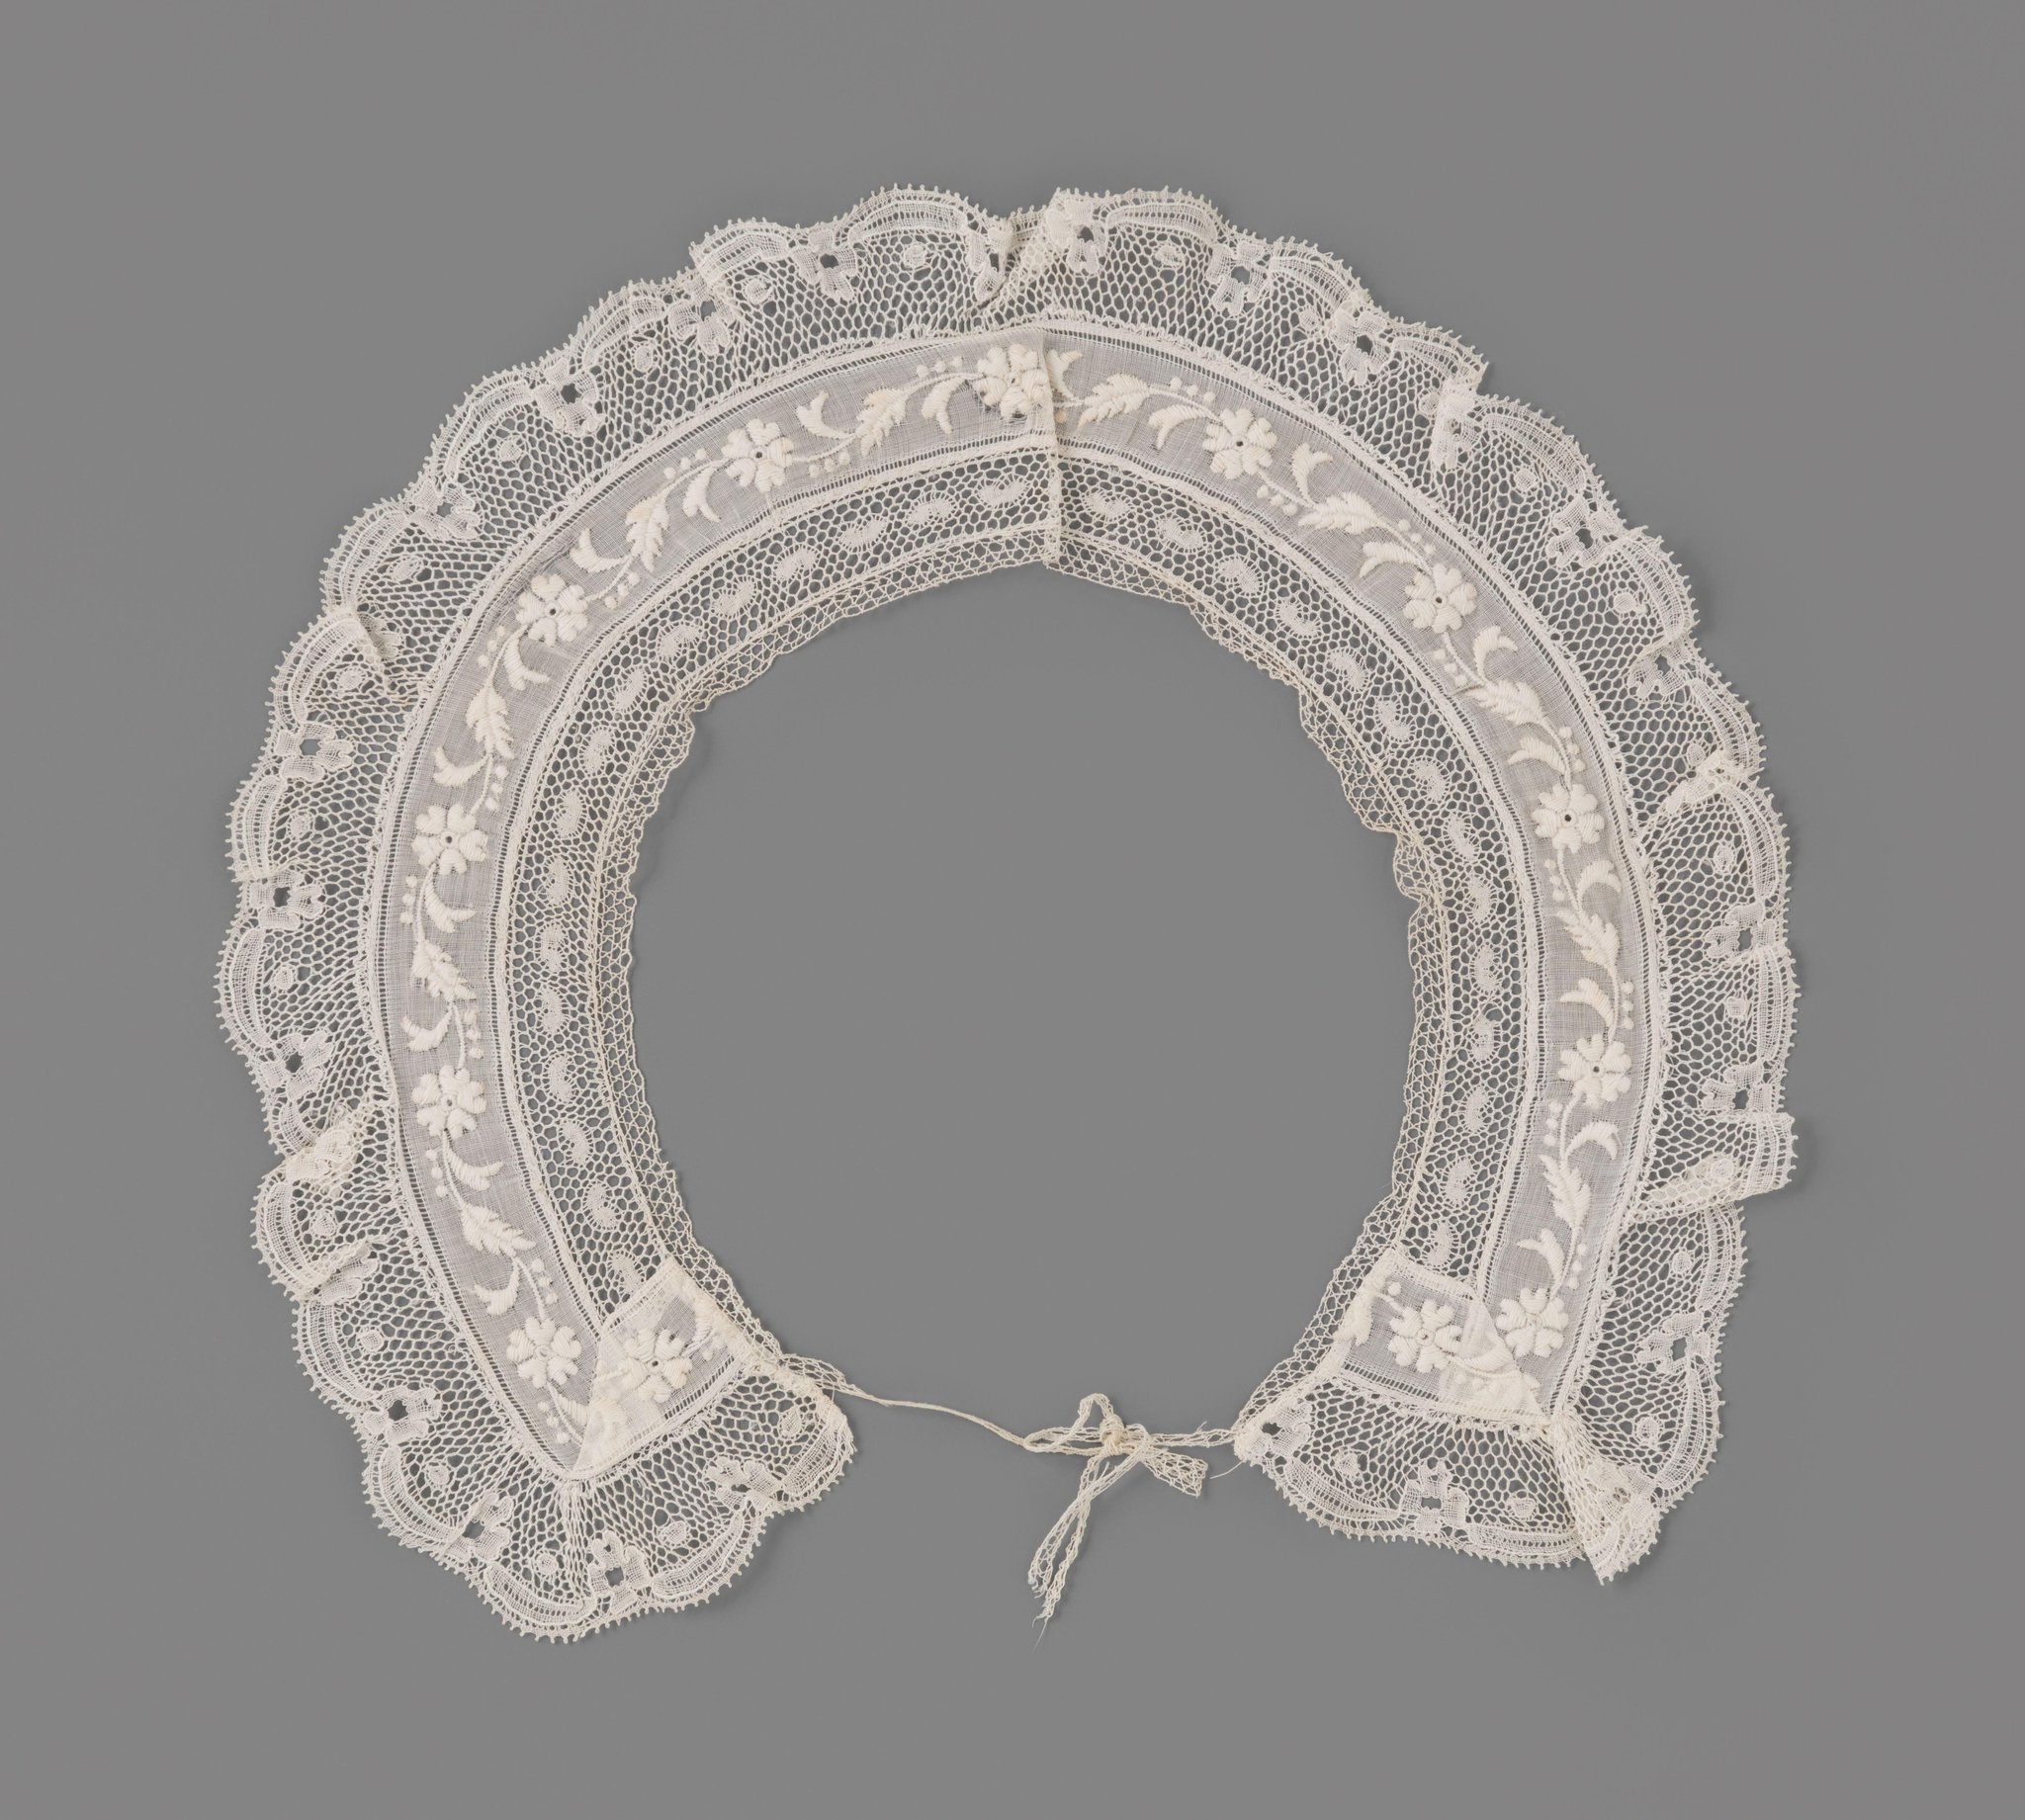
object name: womenswear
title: Kraag van Rijsselse kant met een tussenzetsel van linnenbatist met witwerk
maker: Anonymous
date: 1840-1850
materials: linen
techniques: lace, embroidery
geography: western europe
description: Kraag van Rijsselse kant met een tussenzetsel van linnenbatist met witwerk. De buitenrand is geschulpt en voorzien van picots.